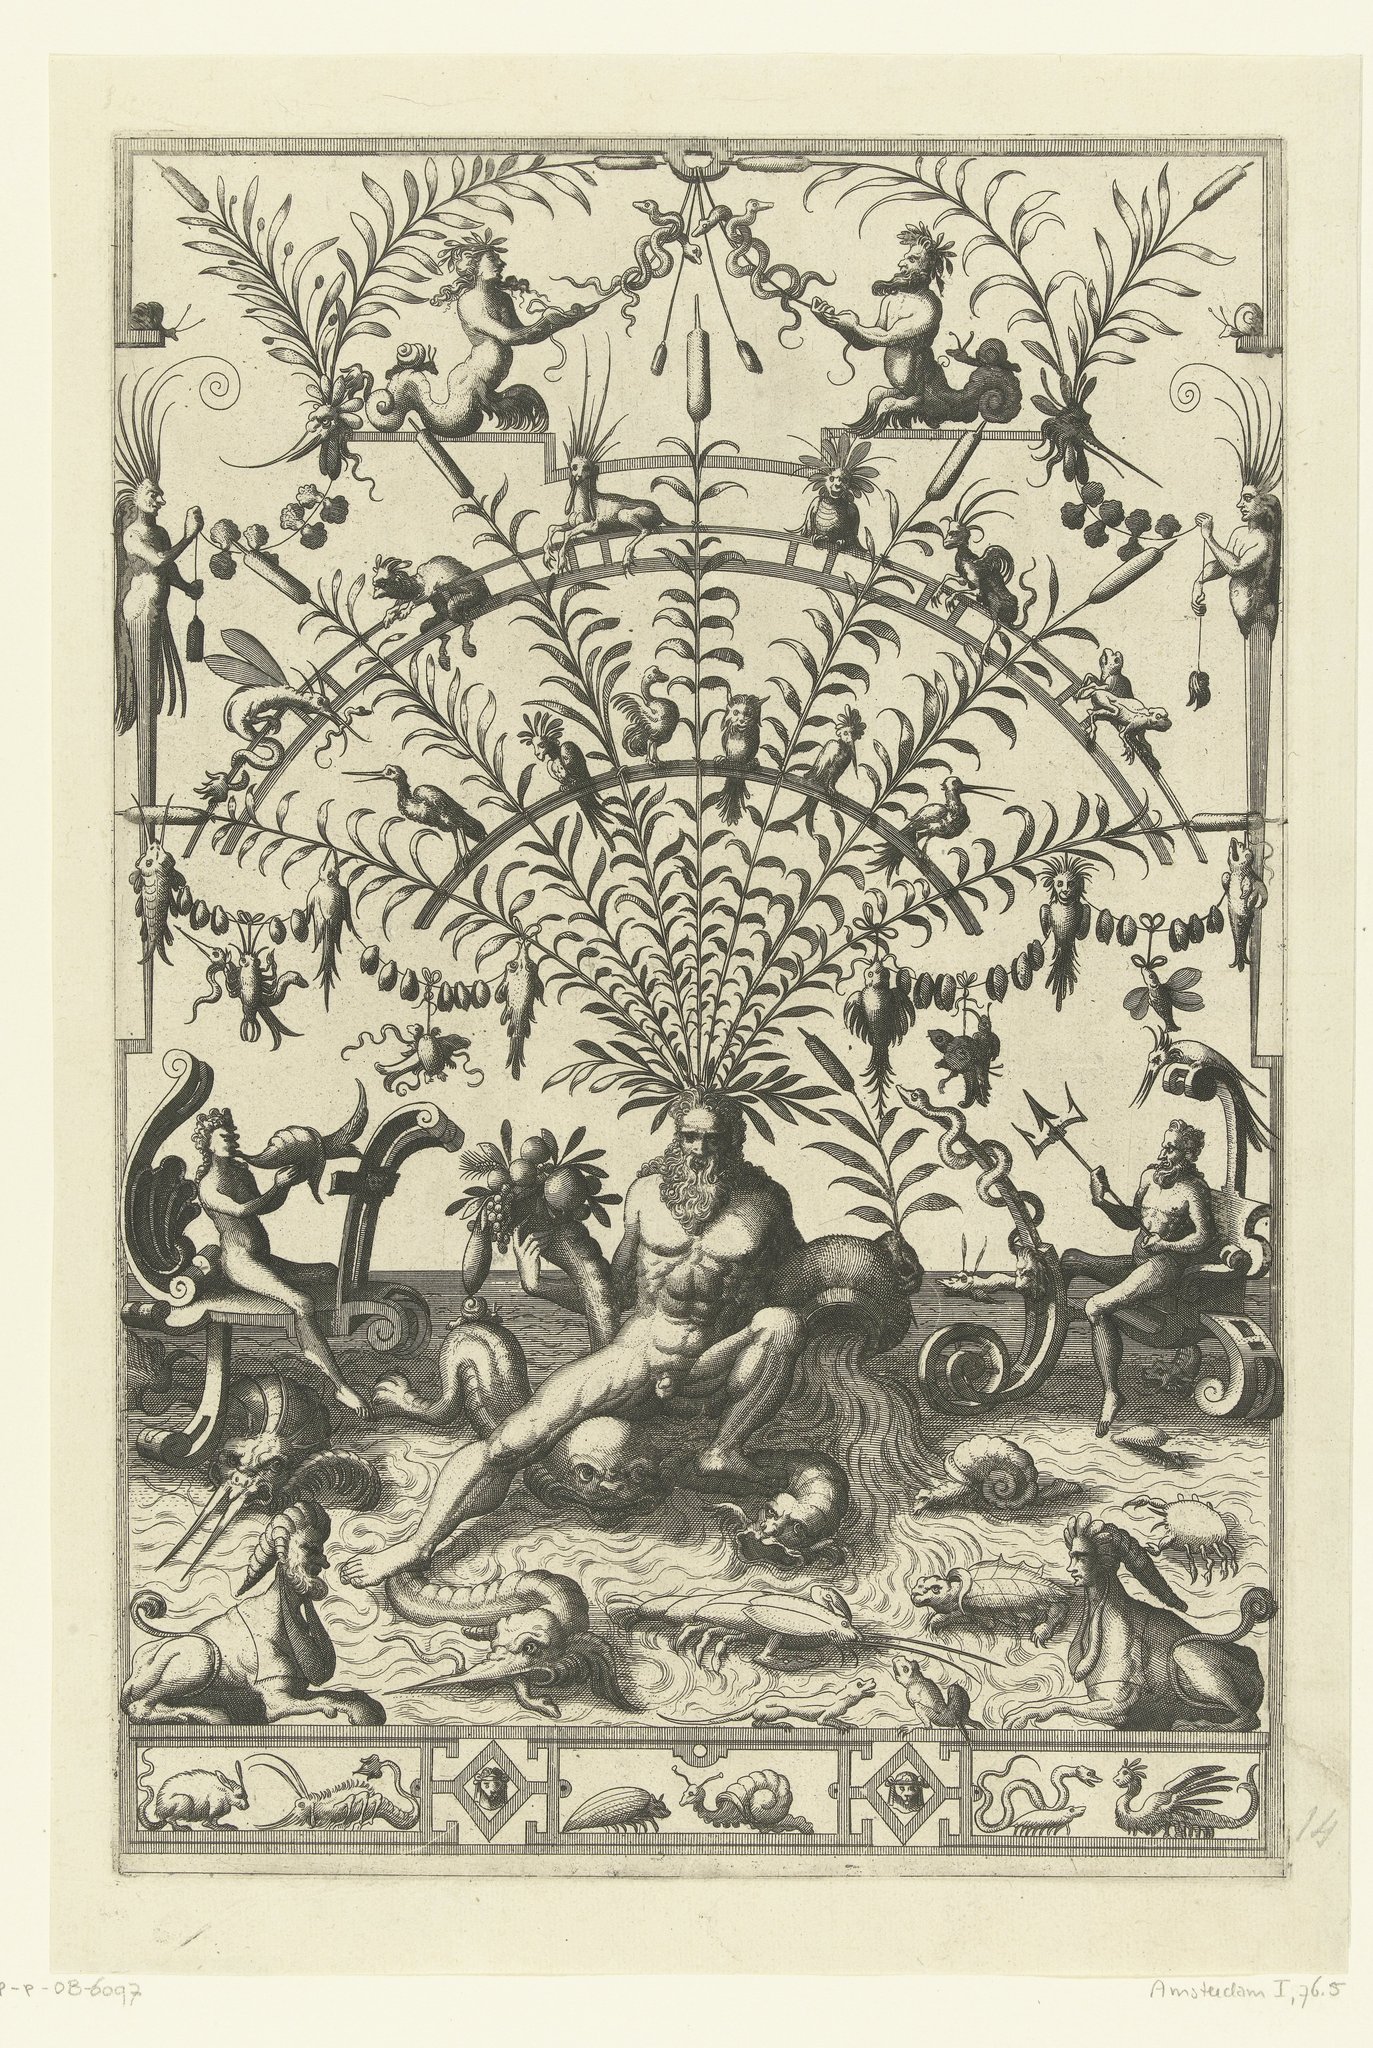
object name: ornament print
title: Vlakdecoraties en grafmonumenten / Veelderleij niewe inventien (...)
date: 1557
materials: paper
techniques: etching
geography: netherlands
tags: ornaments ~ art, river-gods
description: Boven een smal fries met dieren zit een stroomgod met zijn kruik en een hoorn des overvloeds. Hij zit met zijn voeten in een stroom waarin vissen en een dolfijn zwemmen. Tussen de lisdodden die uit zijn hoofd groeien is latwerk bevestigd waarop vogels en andere dieren zitten. Links staat een zetel van rolwerk waarin een vrouw die op een schelp blaast; rechts een zetel met een man met een drietand in zijn hand. Hoort bij serie bestaande uit een titelblad, een tekstblad en 14 bladen met grotesken met rolwerk, saters, guirlandes, trofeeën, dieren en fantasiewezens.